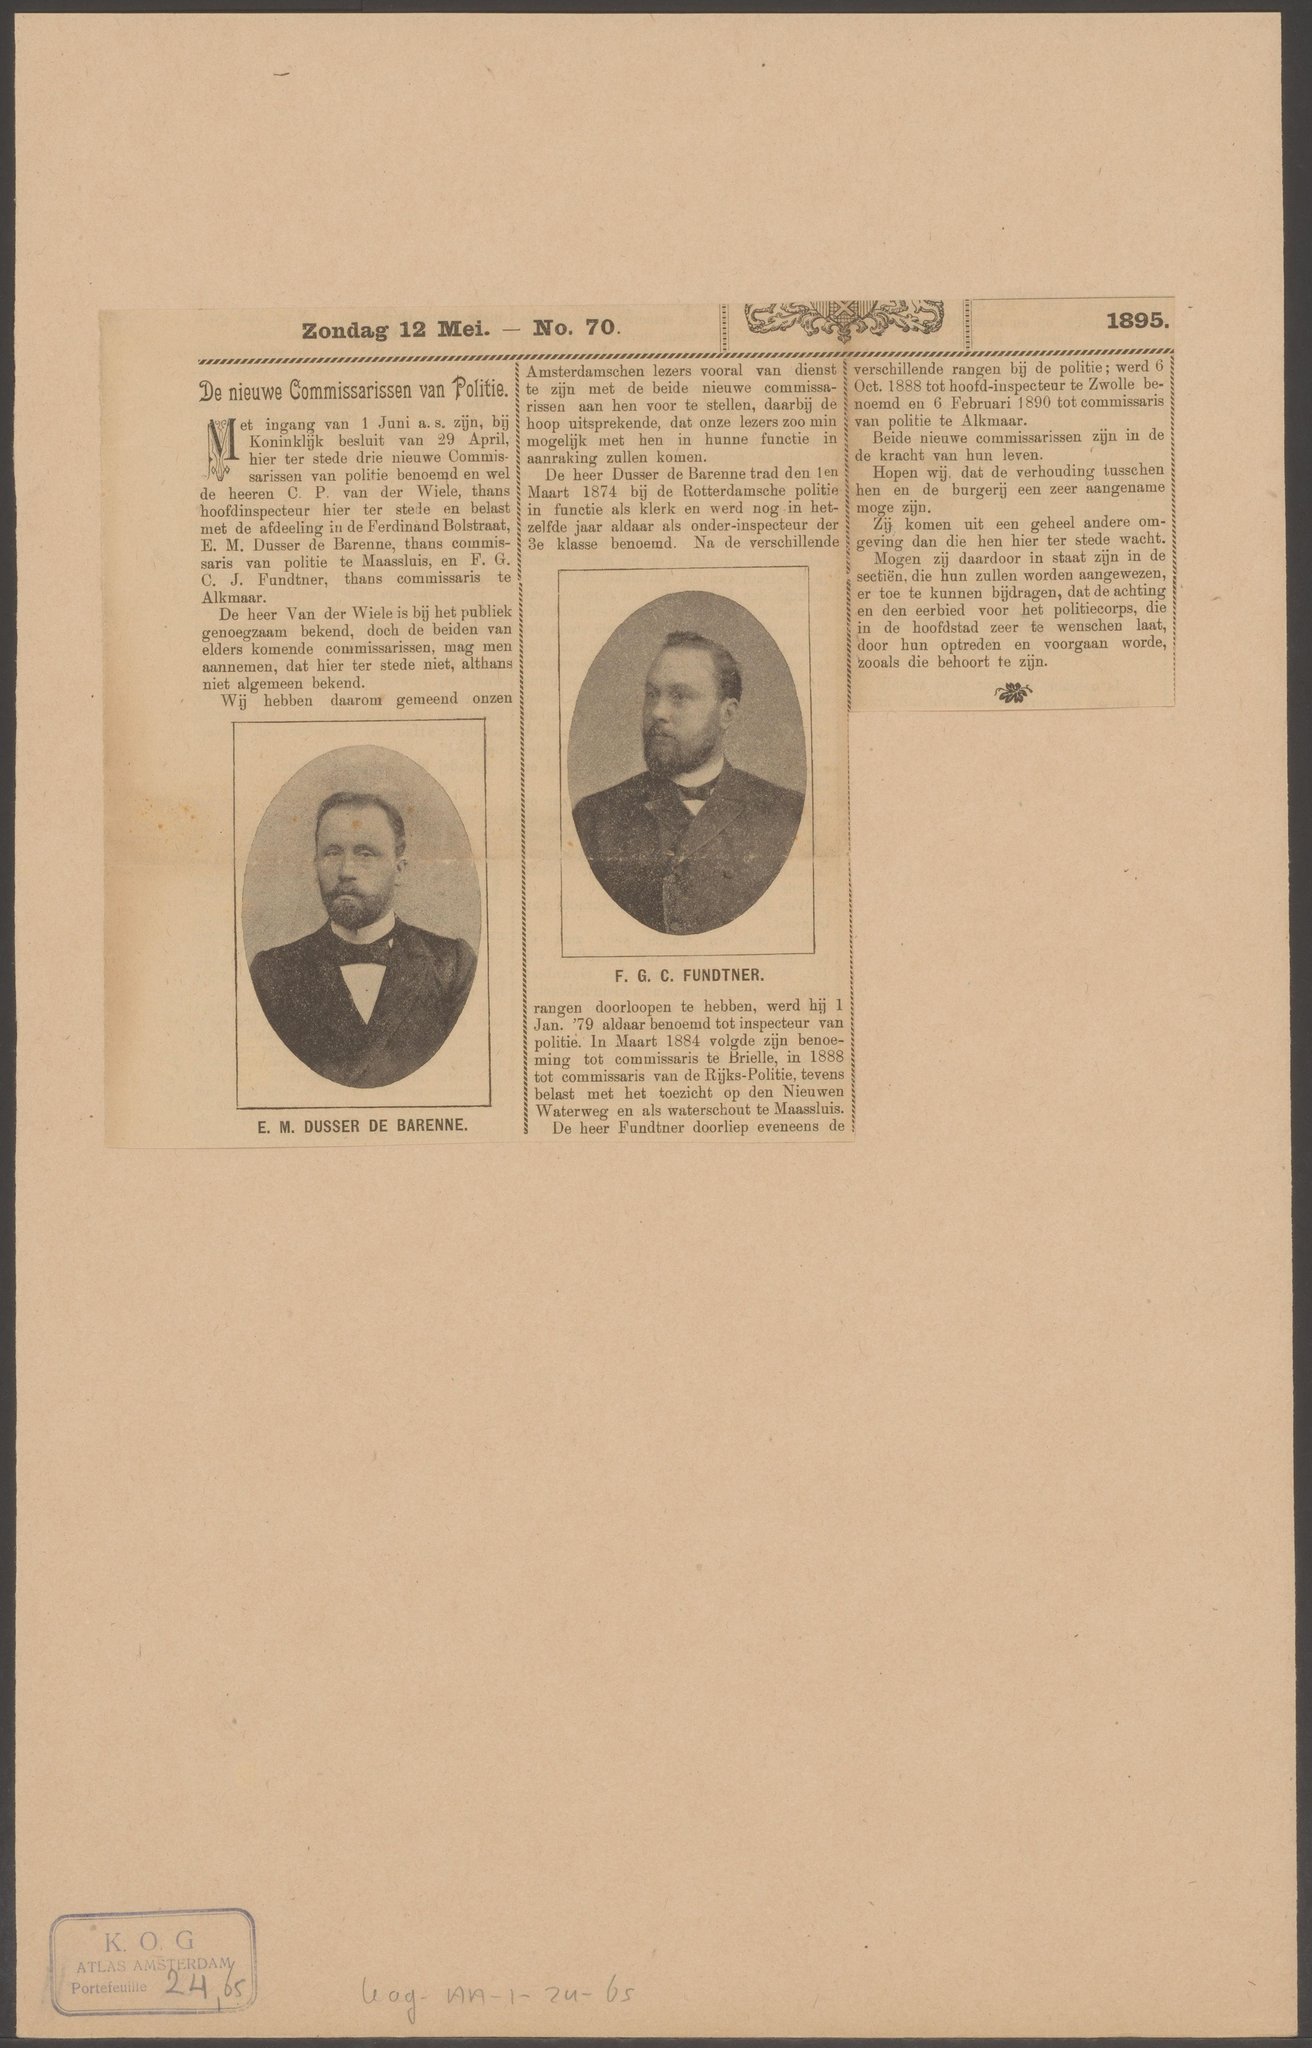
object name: photomechanical print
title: De nieuwe Commissarissen van Politie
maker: Anonymous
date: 1895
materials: paper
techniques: letterpress printing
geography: netherlands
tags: historical persons, amsterdam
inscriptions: collector's mark: Lugt 1641b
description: Onderwerpsrubriek binnen de Atlas Amsterdam: Politie.